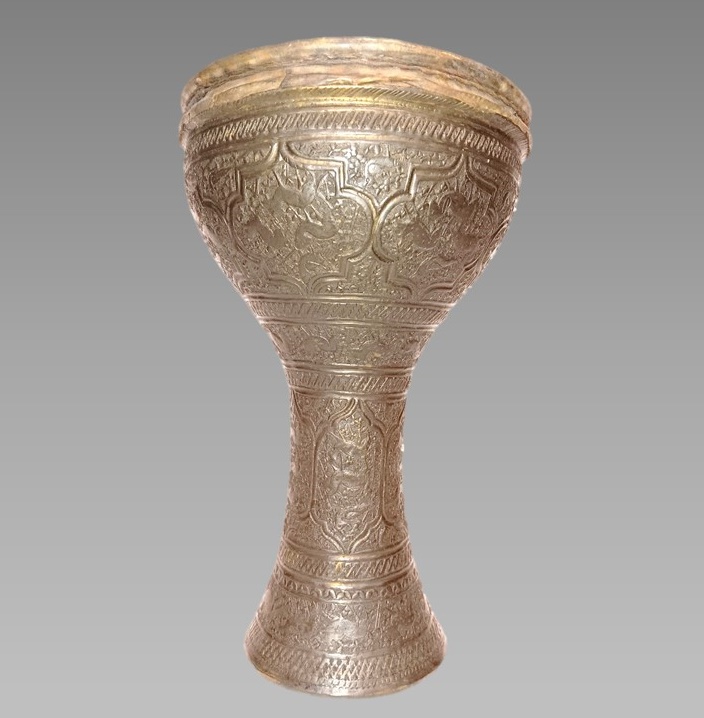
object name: tombak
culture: iranian or persian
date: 1801-1900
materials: brass, parchment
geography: iran